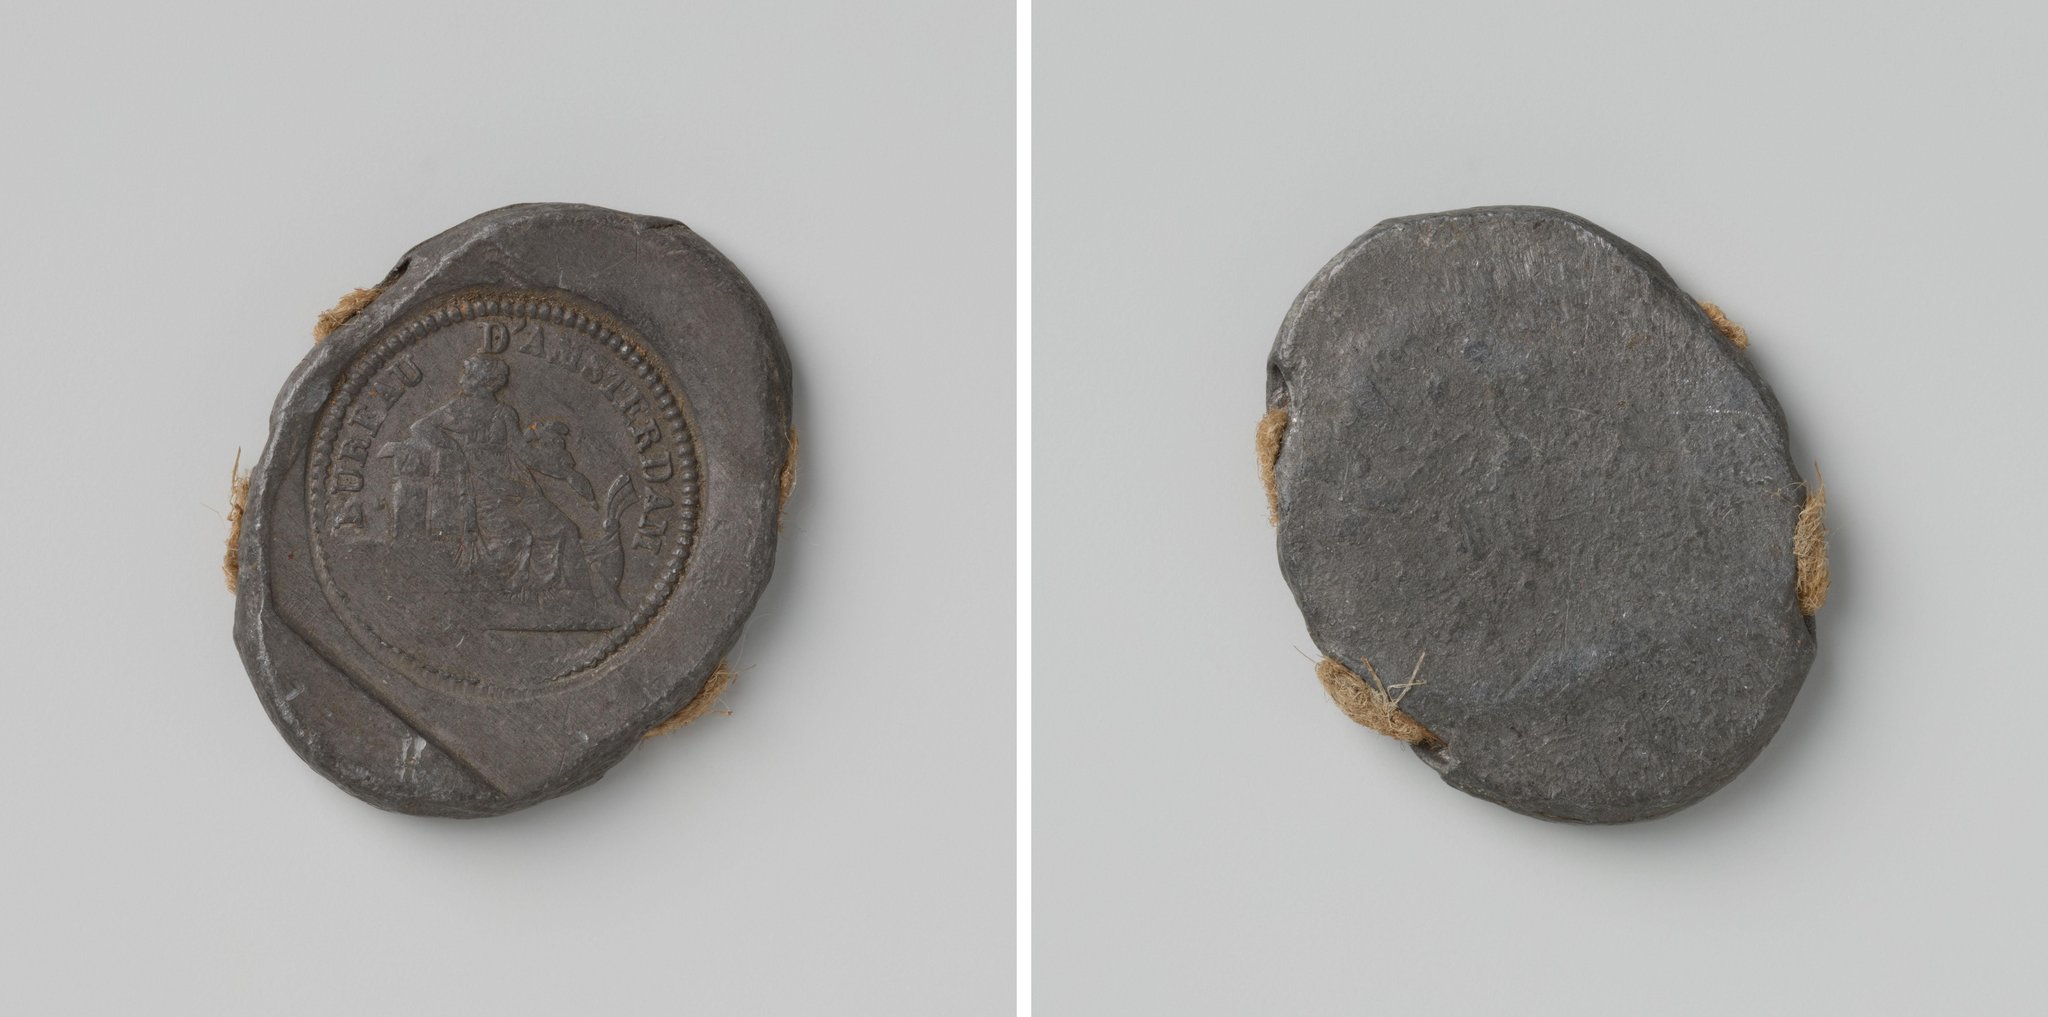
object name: tax token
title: Bureau d'Amsterdam, loodje om te plomberen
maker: Anonymous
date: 1800-1815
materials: lead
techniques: striking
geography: amsterdam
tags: amsterdam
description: enigszins ovaal, eenzijdig loodje met in zijkant gaten, met daarin restanten van touw. Voorzijde: in ronde stempel: vrouw met Mercuriusstaf in linkerhand en met rechterarm leunend op baal; op achtergrond: schip binnen omschrift en parelrand. Keerzijde: blanco